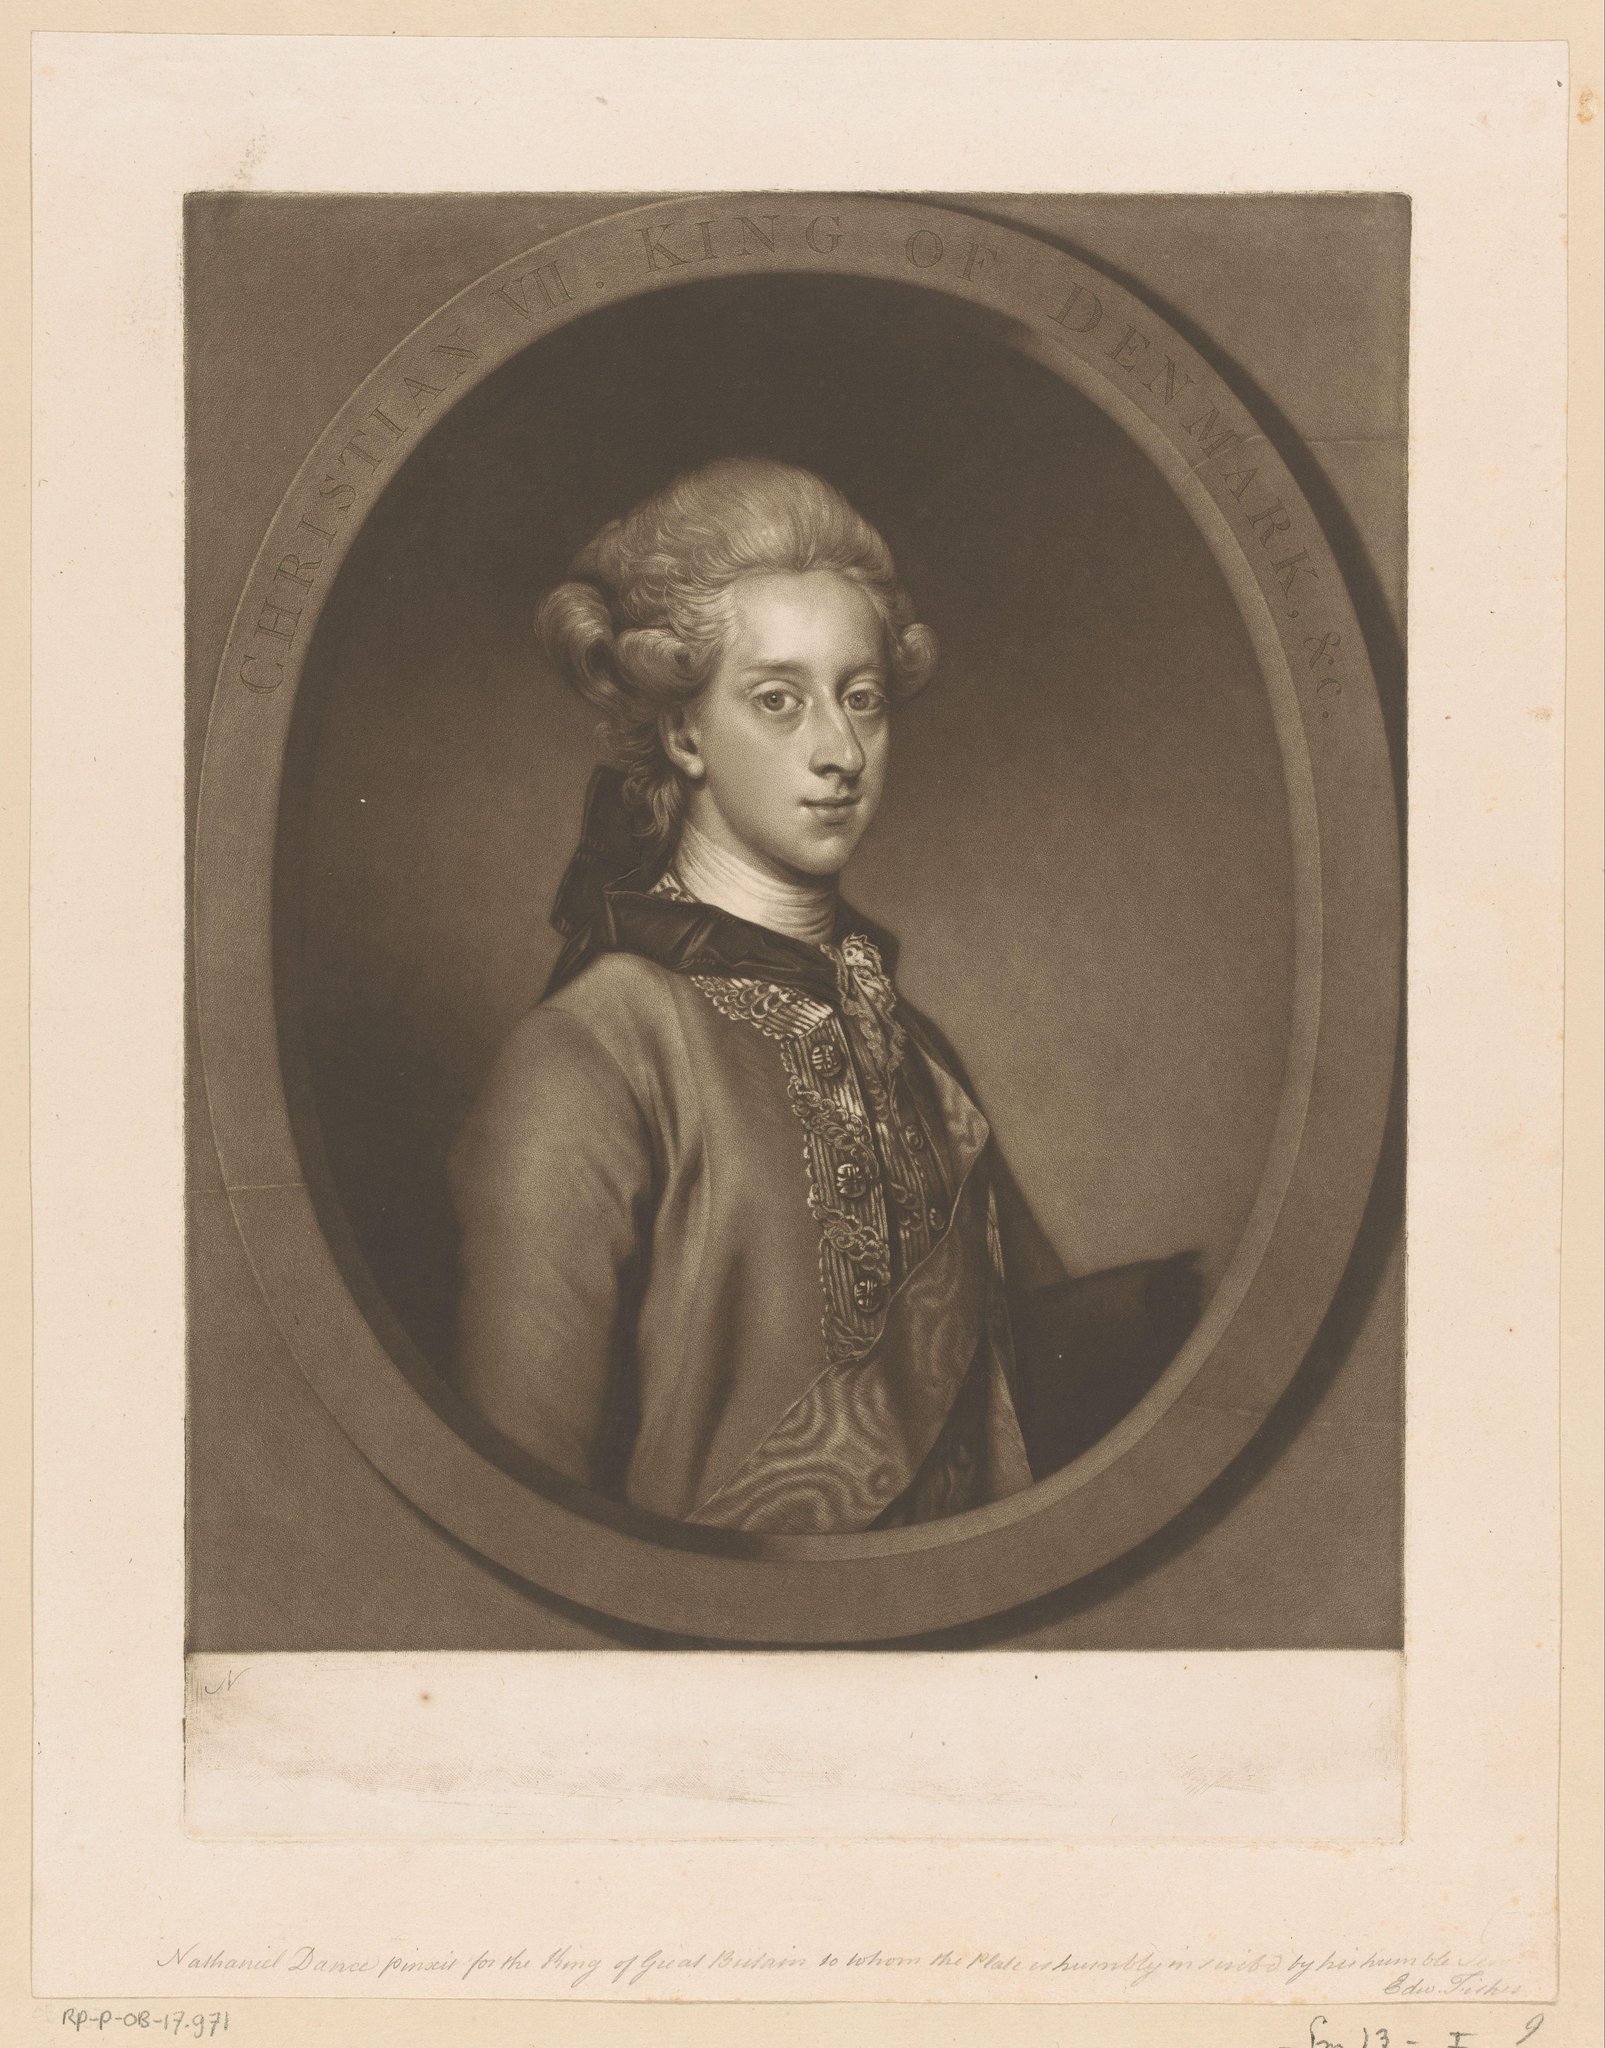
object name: print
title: Christian VII. King of Denmark, &c.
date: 1769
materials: paper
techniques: mezzotint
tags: copenhagen (city), christiaan vii (koning van denemarken), historical persons, king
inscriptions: collector's mark: Lugt 240, inscription: ‘Nathaniel Dance pinxit for the King of Great Britain to whom the plate is humbly inscrib'd by his humble serv. Edw. Fisher’